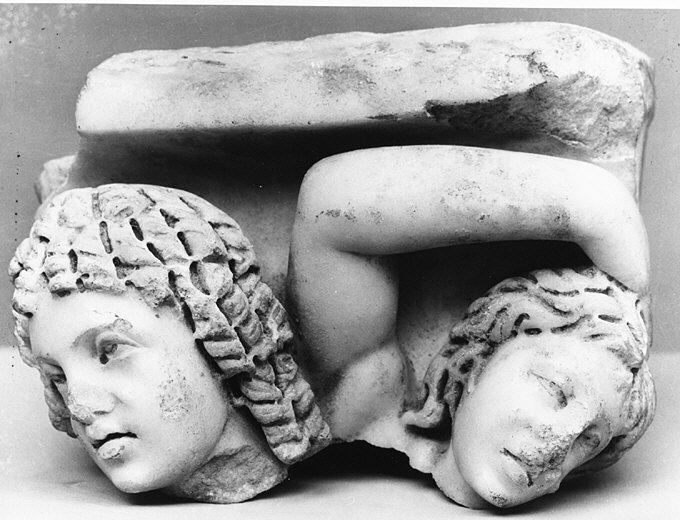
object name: sarcophagus fragment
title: Upper right corner of a marble sarcophagus: head of a Black African and a maenad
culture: roman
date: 201-225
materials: marble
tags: heads,maenads,sarcophagus